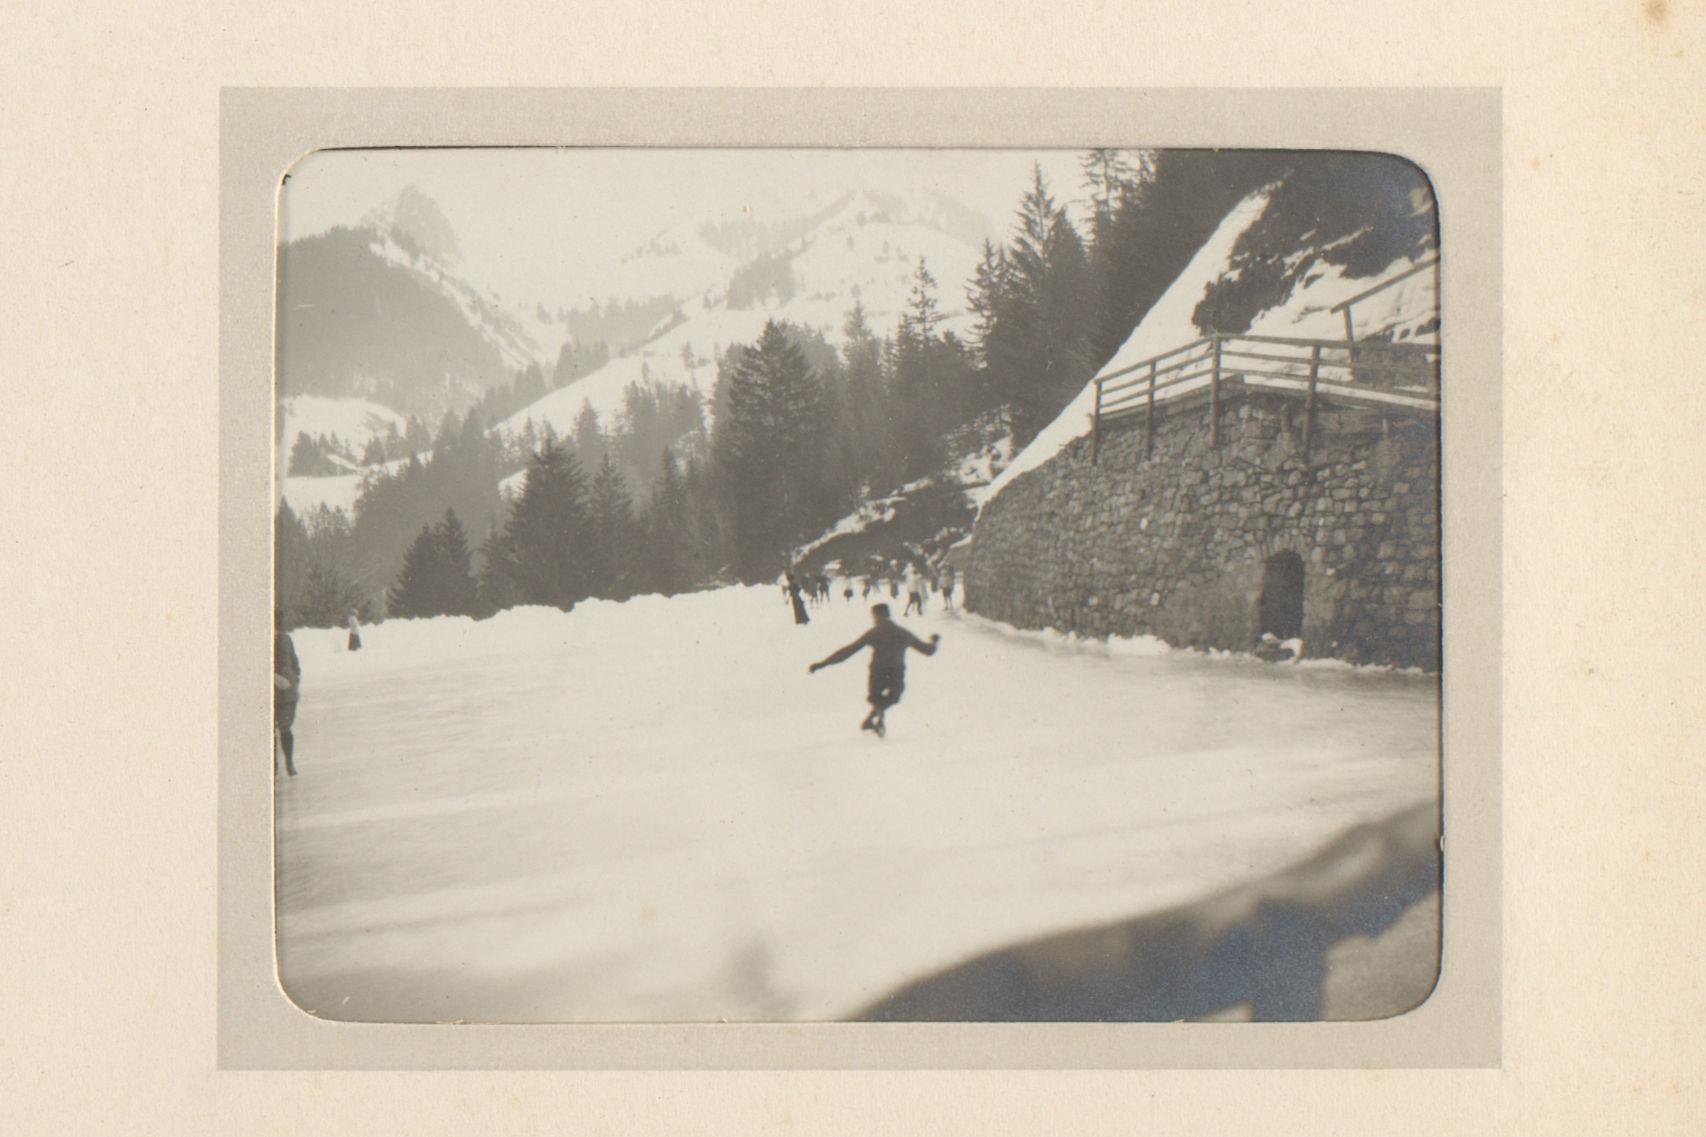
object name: photograph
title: Schaatsers op een bevroren bergmeer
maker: liesbeth overhoff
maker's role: fotograaf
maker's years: 1895-1969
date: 1911-1915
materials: paper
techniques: gelatin silver print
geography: territet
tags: water course, skates (winter sports)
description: Dit bevroren bergmeer is ook afgebeeld op RP-F-F01201-10-3.